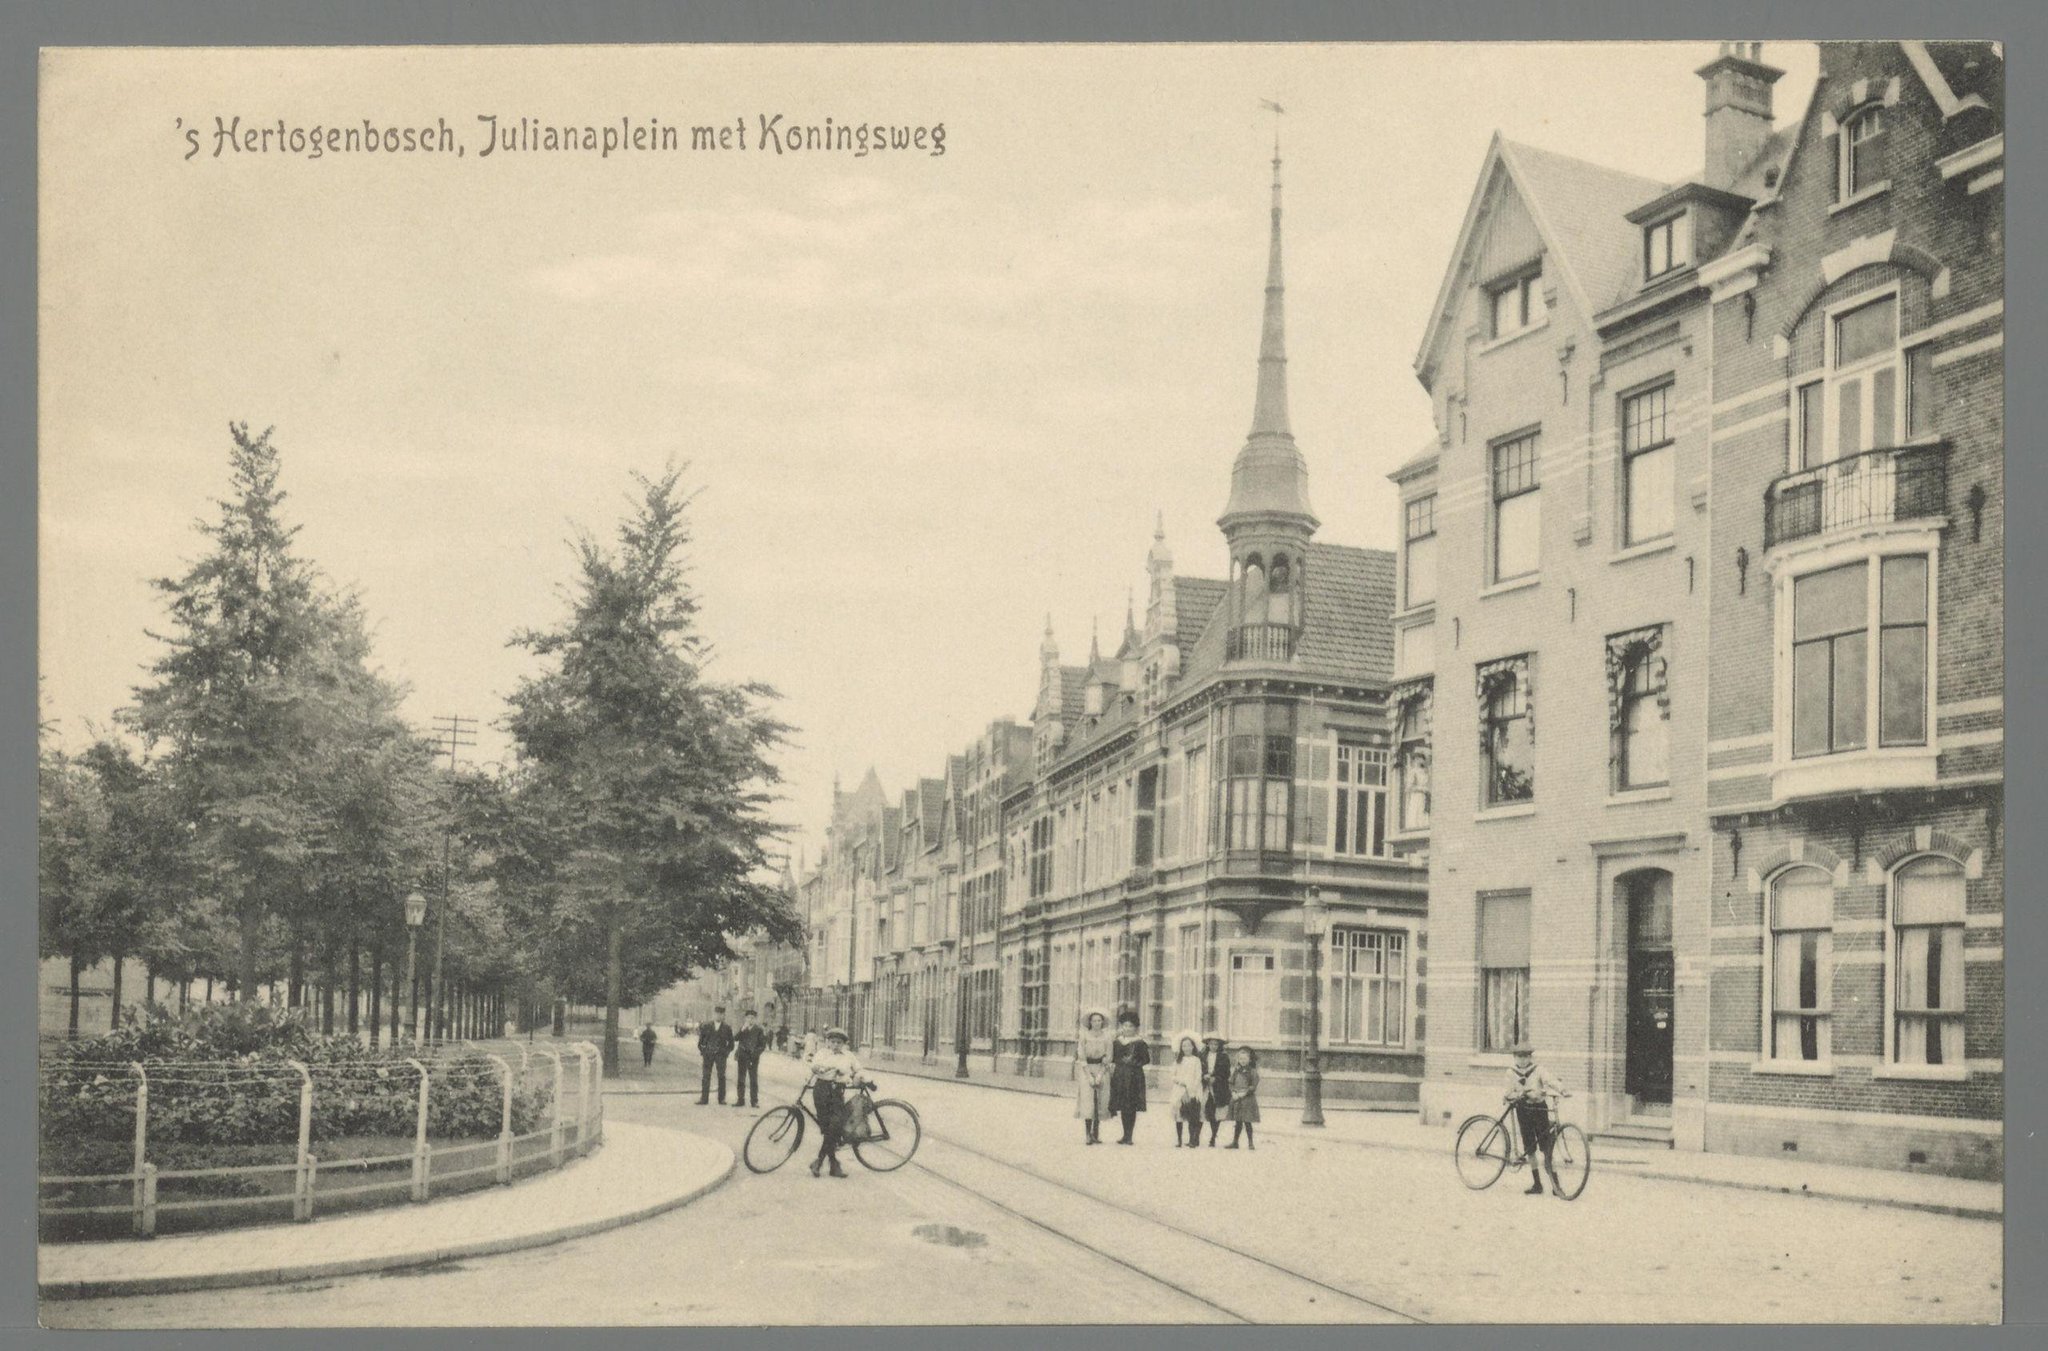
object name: photomechanical print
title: 's Hertogenbosch, Julianaplein met Koningsweg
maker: Anonymous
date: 1912-1930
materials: cardboard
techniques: photograph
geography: den bosch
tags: street, den bosch